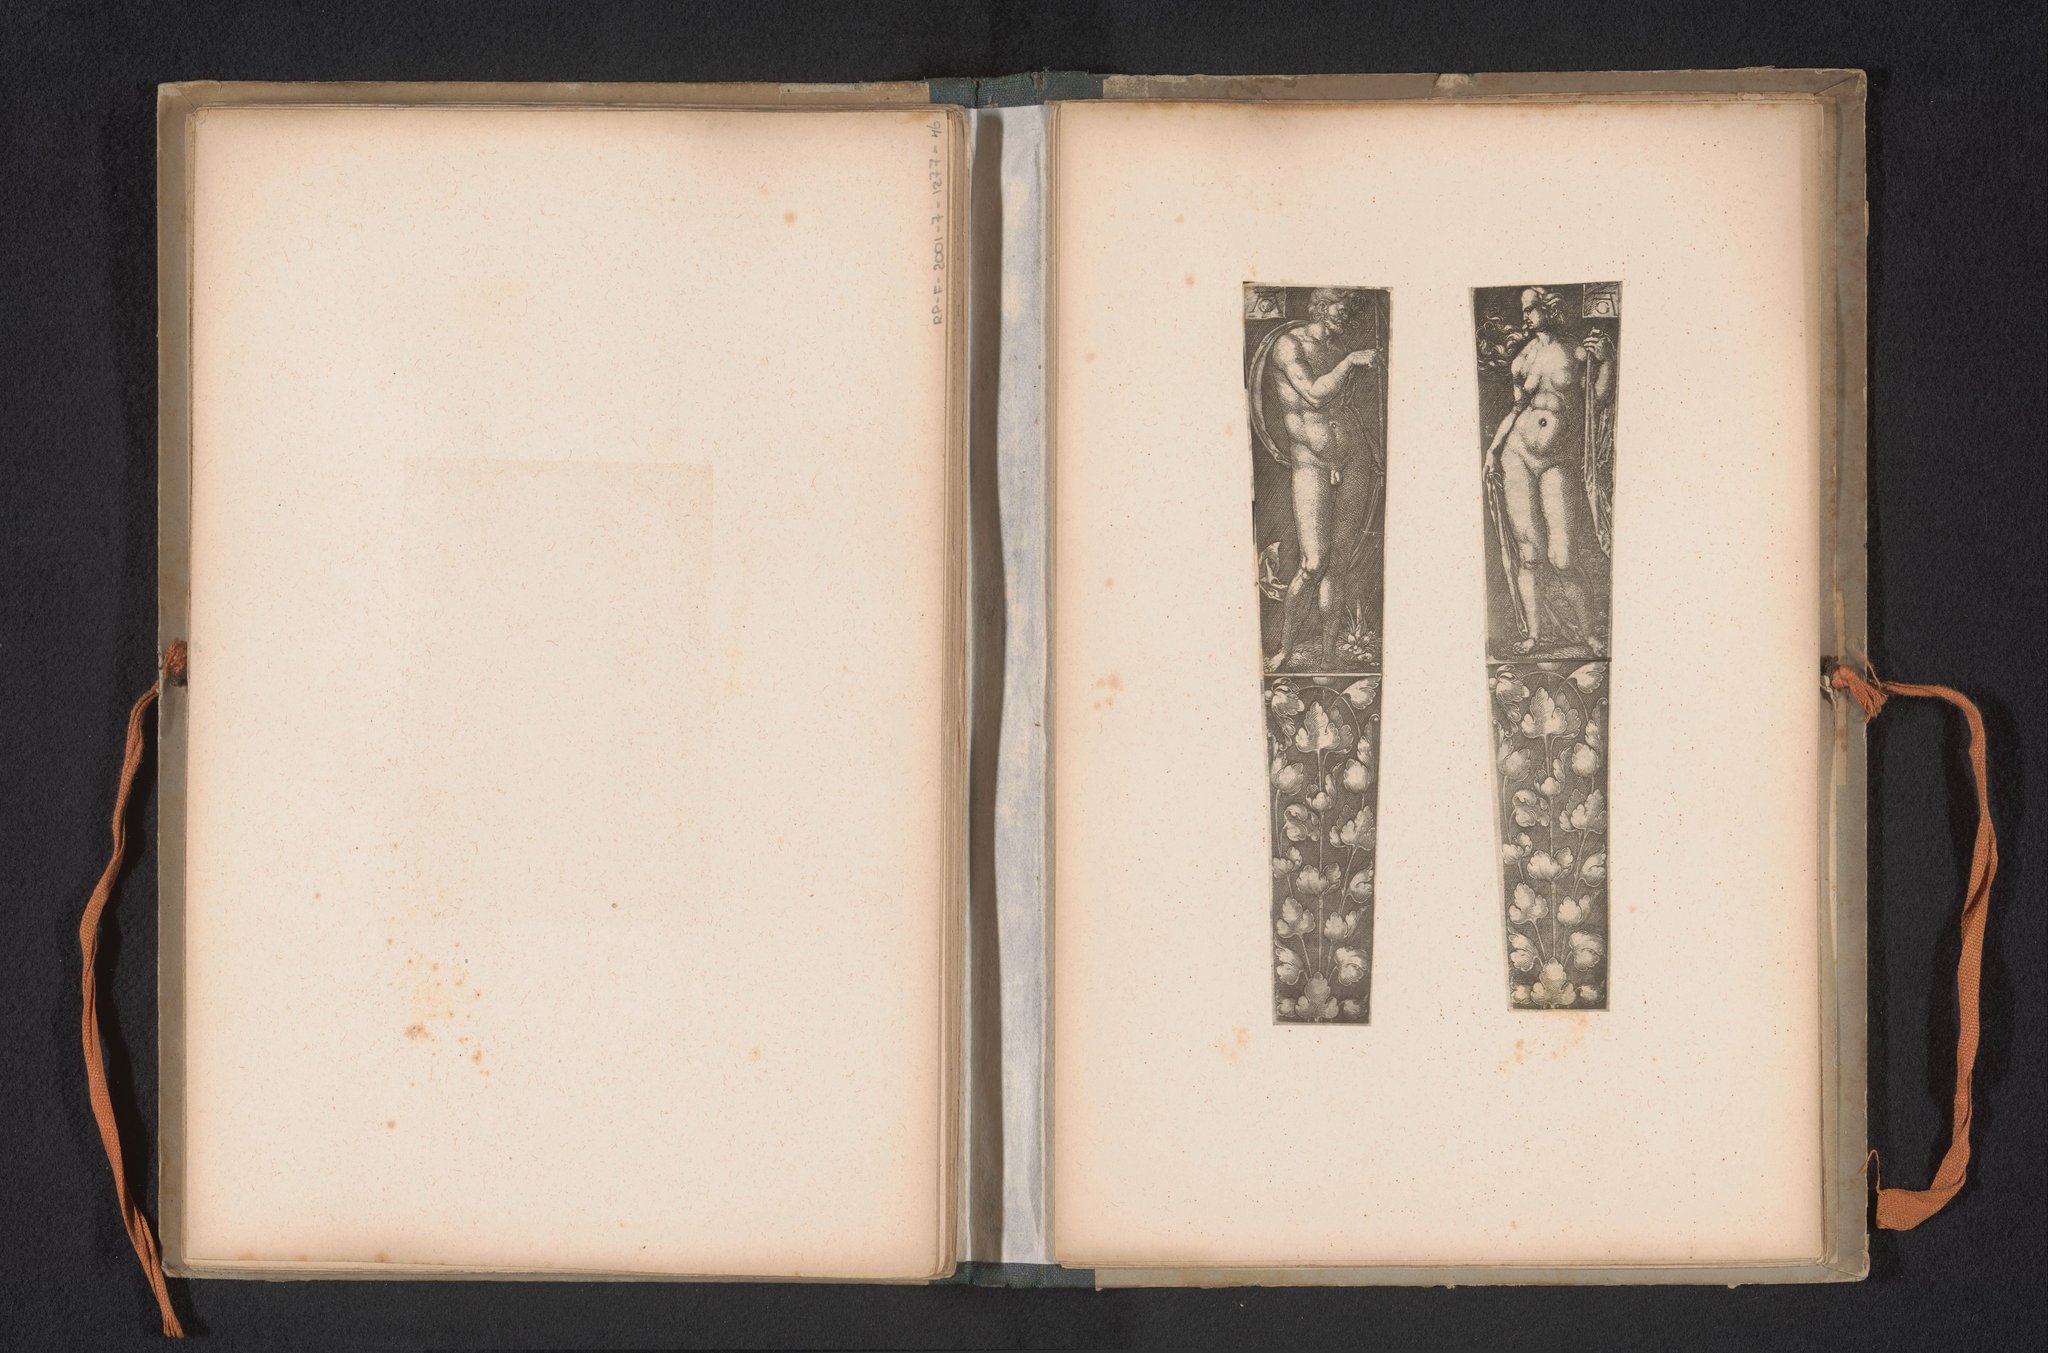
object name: reproduction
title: Reproductie van een prent van een man en bladeren door Heinrich Aldegrever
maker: heinrich aldegrever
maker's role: draughtsman, print maker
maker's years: 1502-1561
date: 1866-1871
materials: paper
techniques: woodburytype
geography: brussels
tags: adult man, foliage, tendrils, branches ~ ornament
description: Deze prent maakt deel uit van een omslag met 57 prenten op 54 bladen.